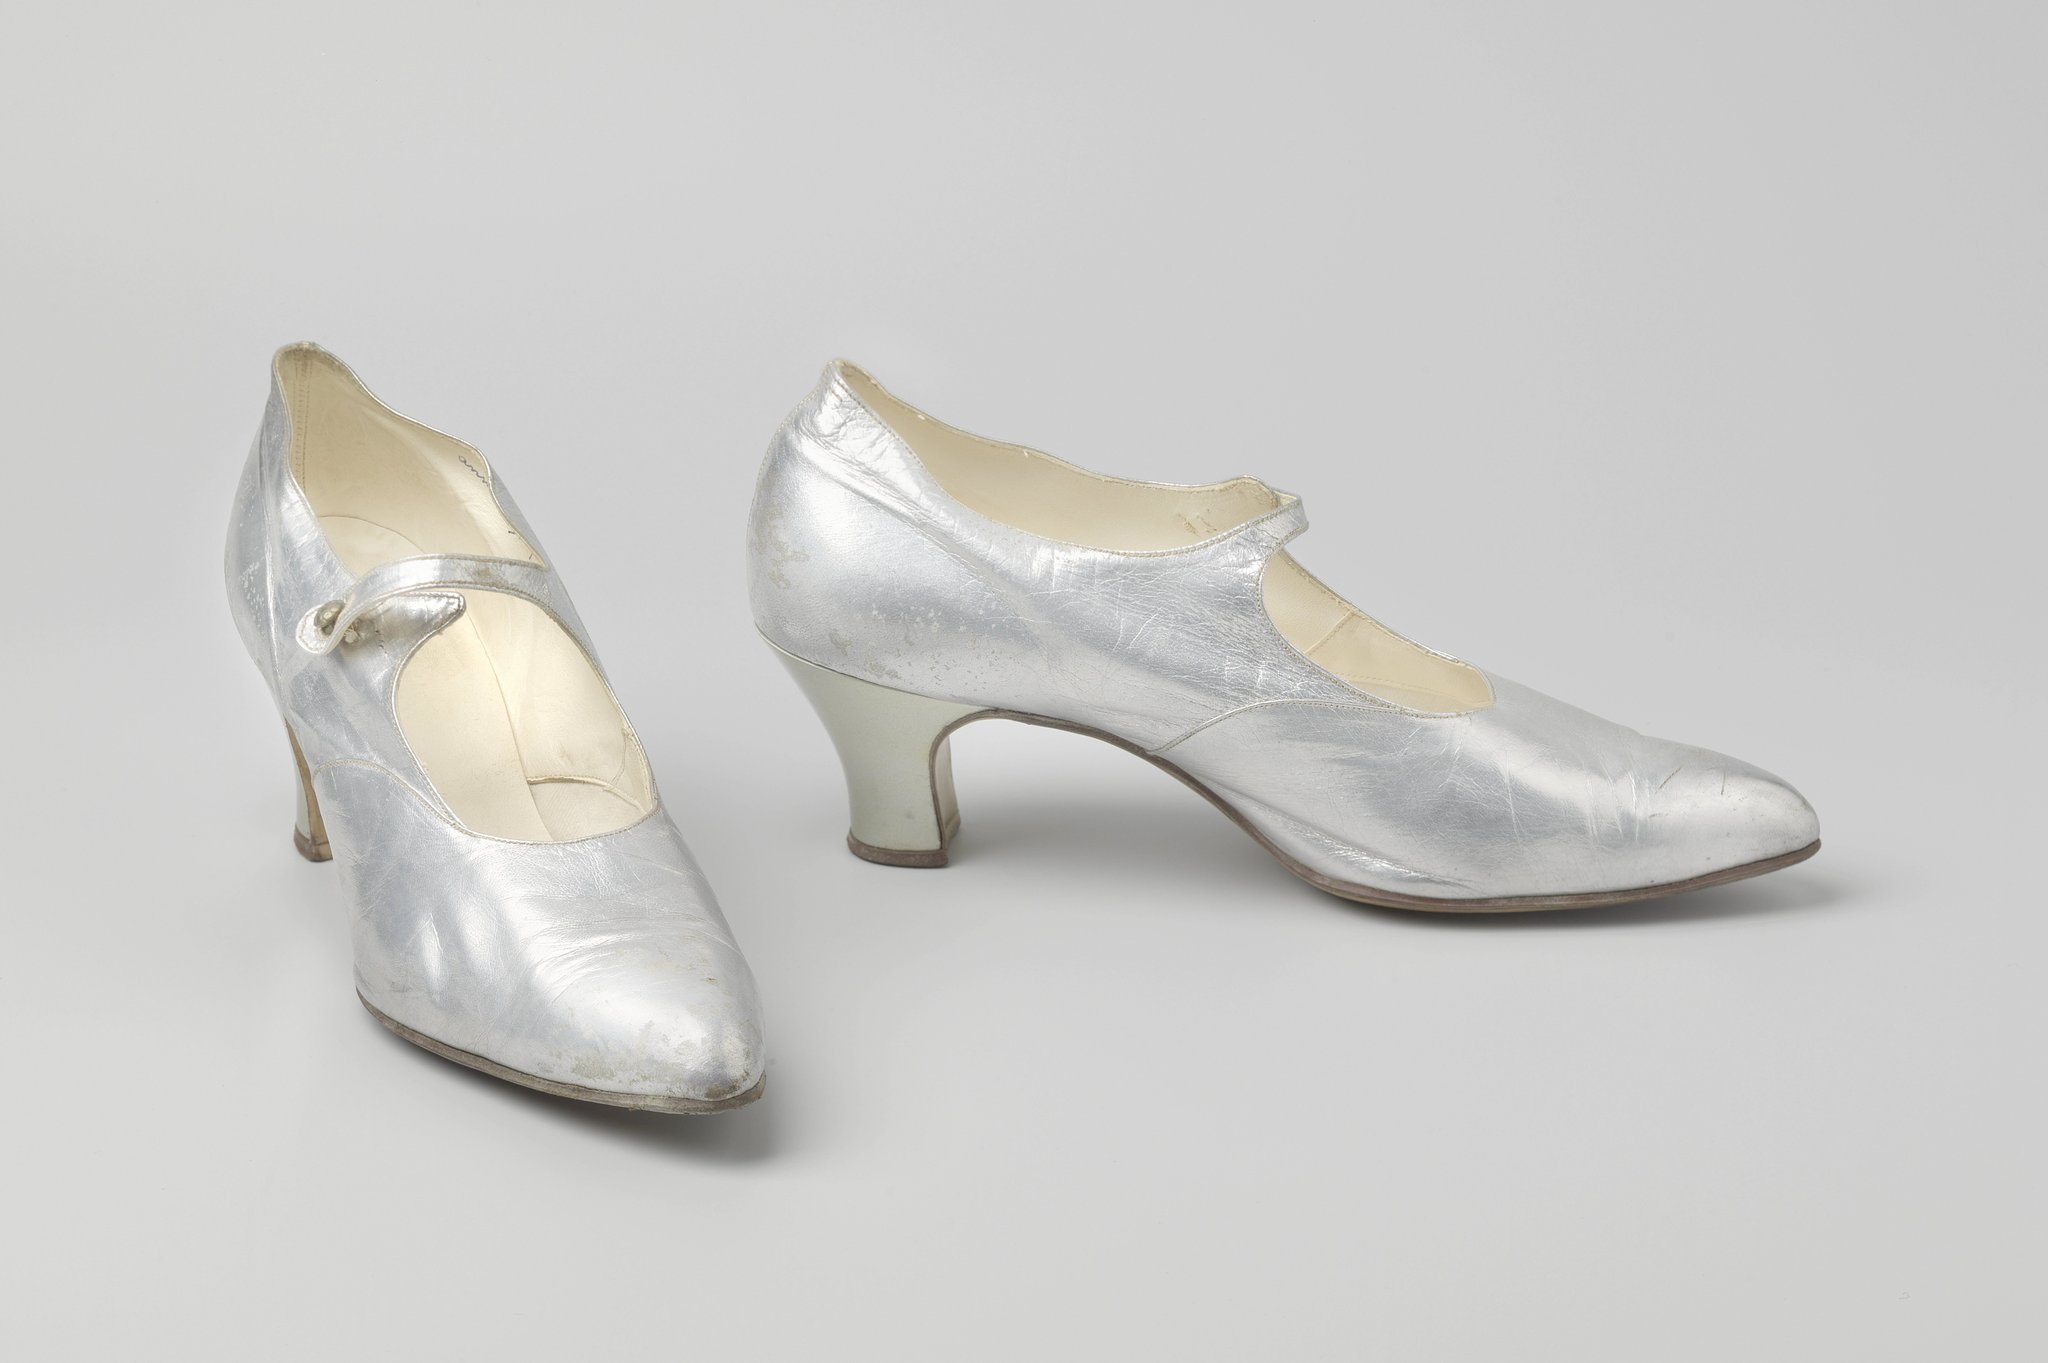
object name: avondschoen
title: Avondschoen met riempjes van zilver leer, extreem scherpe neus en hoog uitgesneden voorblad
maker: Anonymous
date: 1928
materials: leather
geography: northampton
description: Avondschoen met riemen van zilver leer. Extreem scherpe neus. Hoog uitgesneden voorblad. Plompe, middelhoge hak. Koperen knoopjes aan een oogje. Voering van wit glacéleer. Met doos van Manfield.